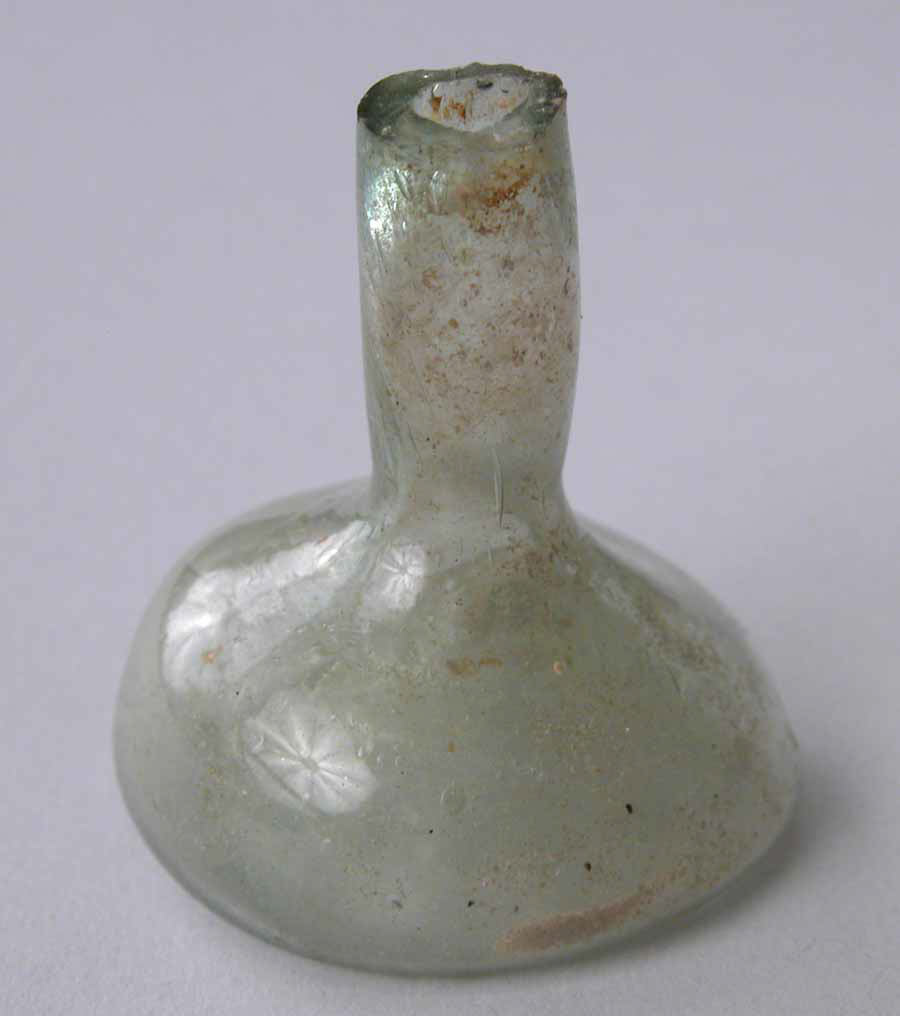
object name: bottle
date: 801-900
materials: glass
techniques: glassblowing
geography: iraq